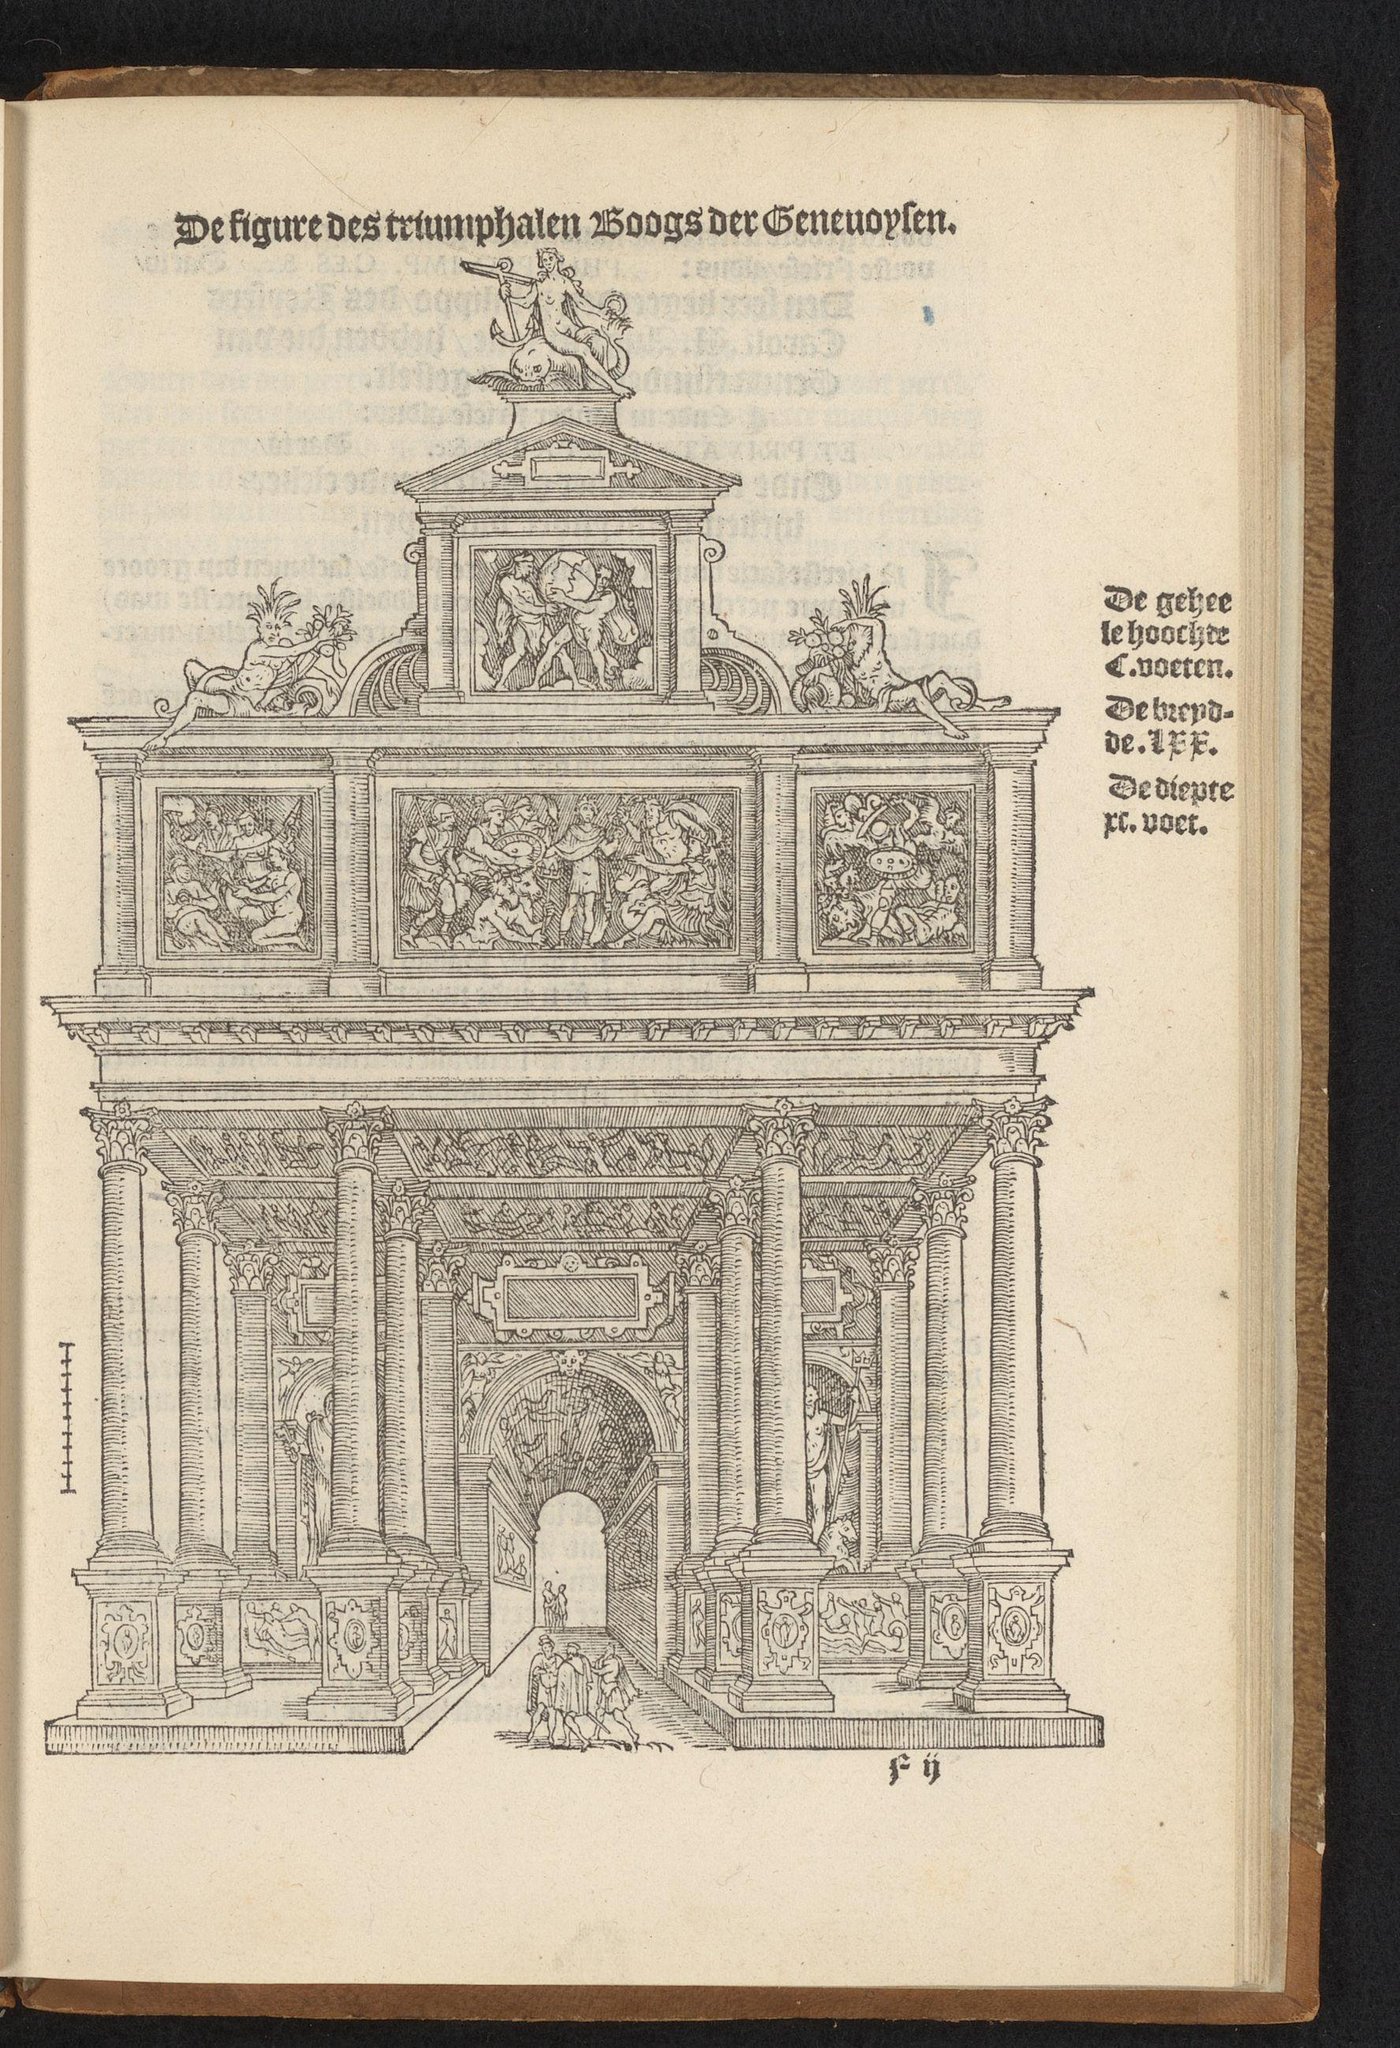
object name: print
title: Den Triumphalen Boge der Geneuoysen / inde gasthuystrate by den drijhoeck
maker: pieter coecke van aelst (i)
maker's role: draughtsman, print maker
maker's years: 1502-1550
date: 1549-1550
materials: paper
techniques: woodcut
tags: philip ii of spain, triumphal arch, antwerp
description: Illustratie in de Nederlandse vertaling van de beschrijving van de intocht van Filips II in Antwerpen in 1549: De seer wonderlijcke schoone triumphelijcke incompst, van den hooghmogenden Prince Philips, Prince van Spaignen, Caroli des vijfden, Keysers sone : inde stadt van Antwerpen, Anno 1549. Tekst van Cornelius Grapheus, waarschijnlijk vertaald uit het Latijn door Gillis van Diest, opgedragen aan Filips II, uitgegeven met keizerlijke privilege door Pieter Coecke van Aelst, gedrukt door Gillis van Diest. Boek in de bibliotheek met signatuur: 325 B 12.